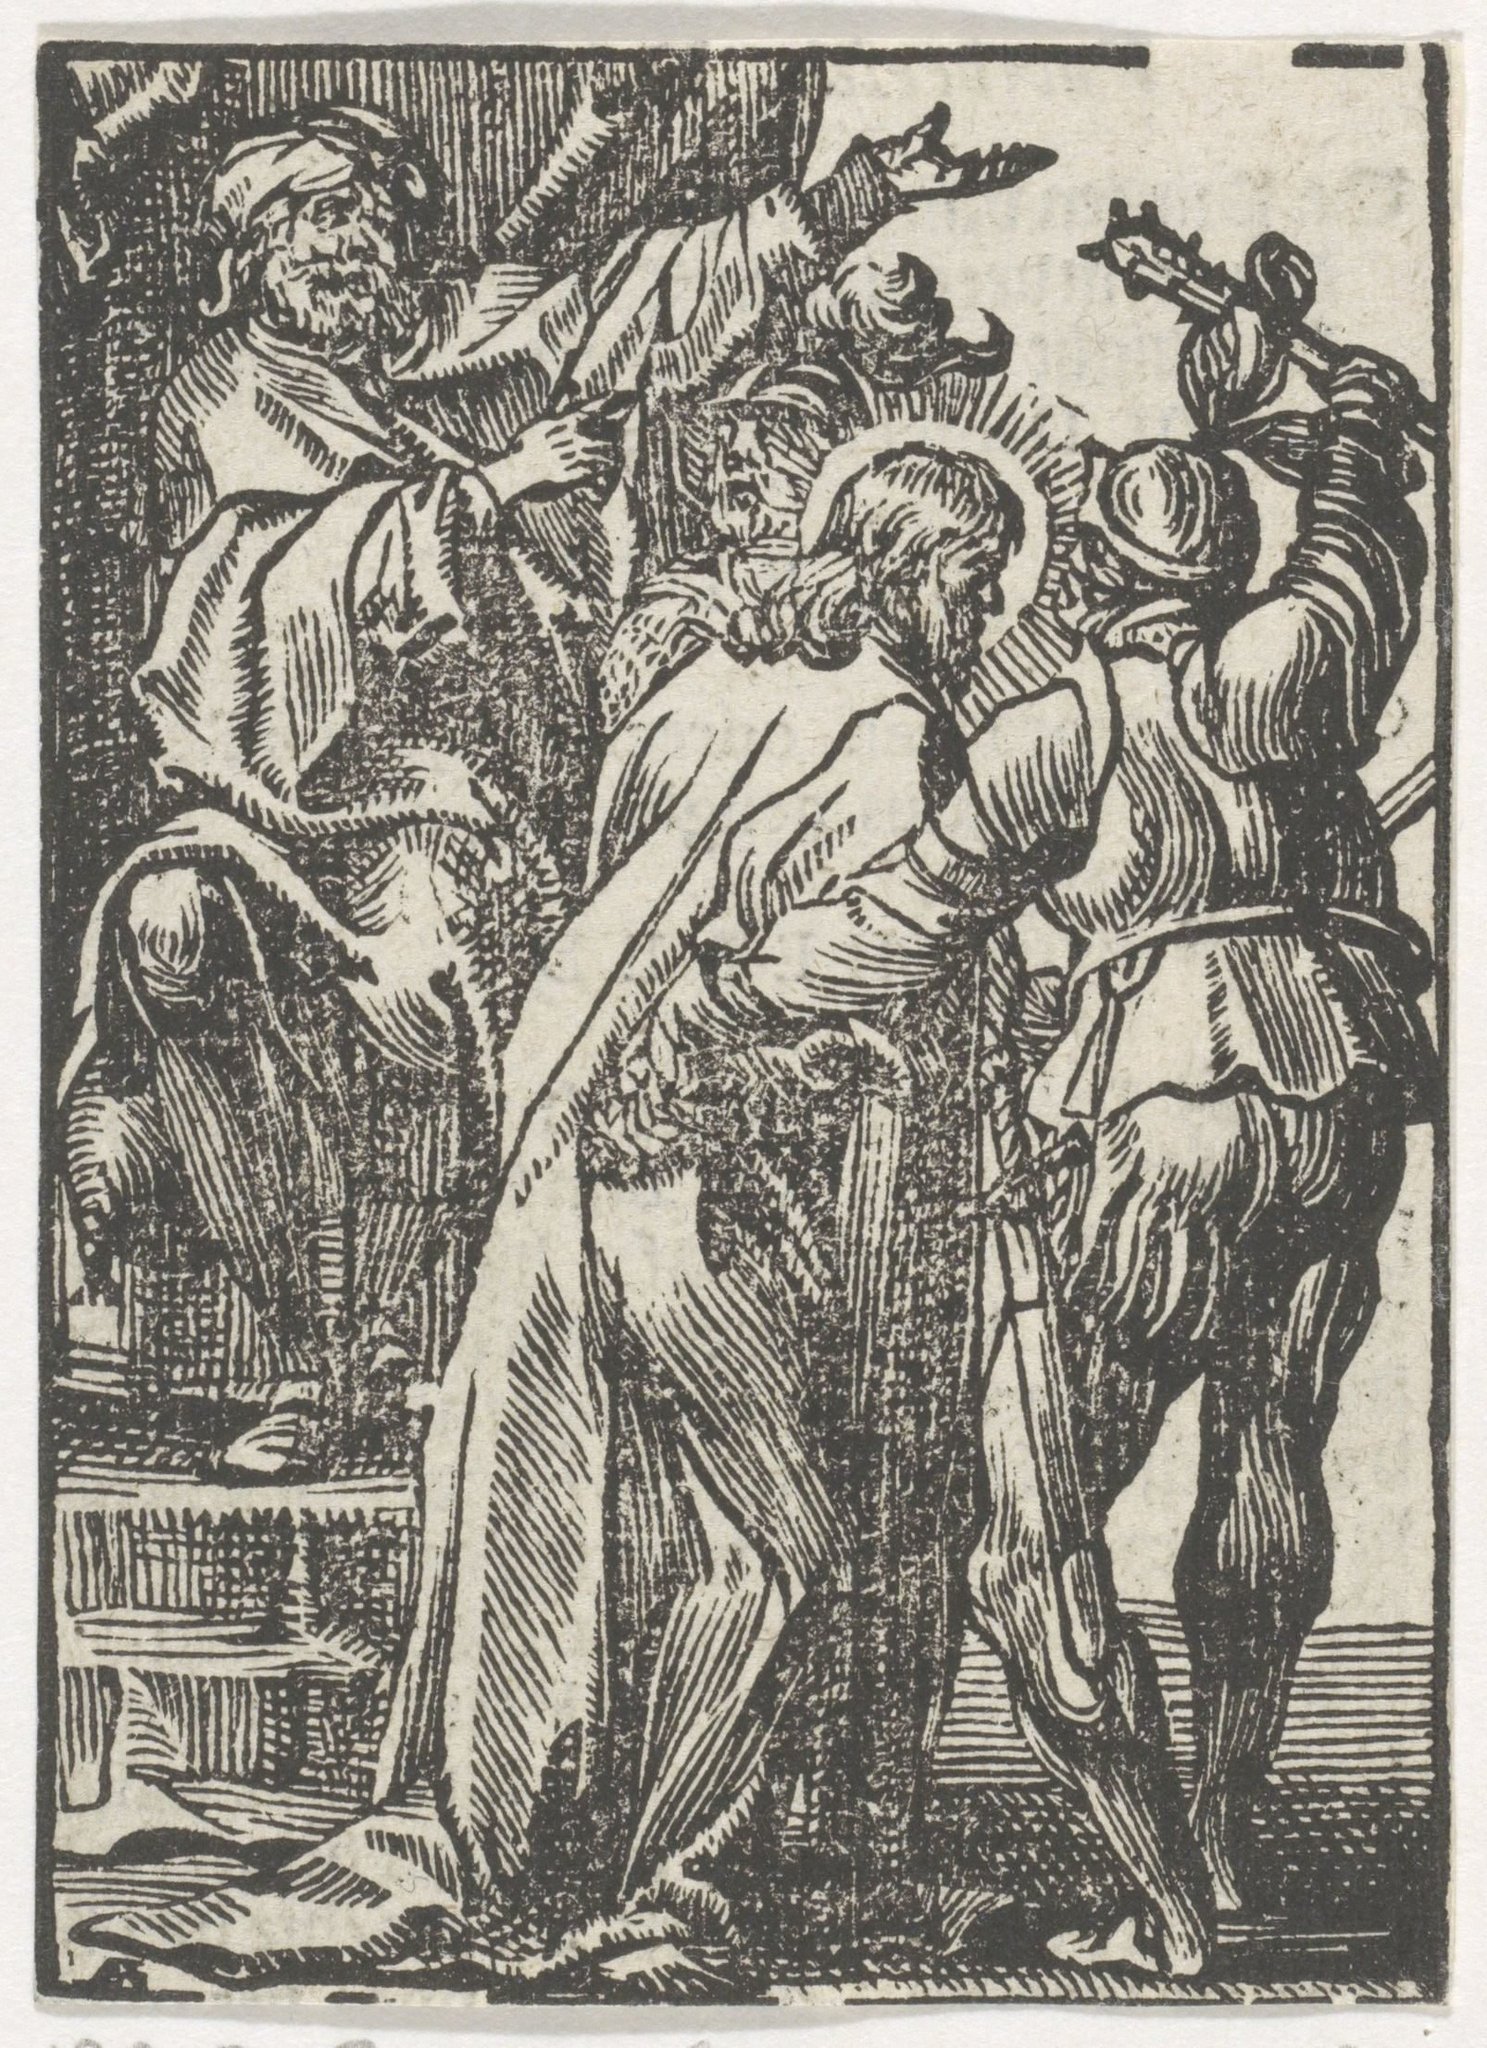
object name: print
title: Christus voor Herodes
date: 1649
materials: paper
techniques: letterpress printing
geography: antwerp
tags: christ before king herod; sometimes a gorgeous robe is brought (luke 23:8-11)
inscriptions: collector's mark: Lugt 2228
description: Koning Herodes ondervraagt Christus, maar die antwoordt hem niet. Hierop bespotten Herodes en zijn soldaten Christus.